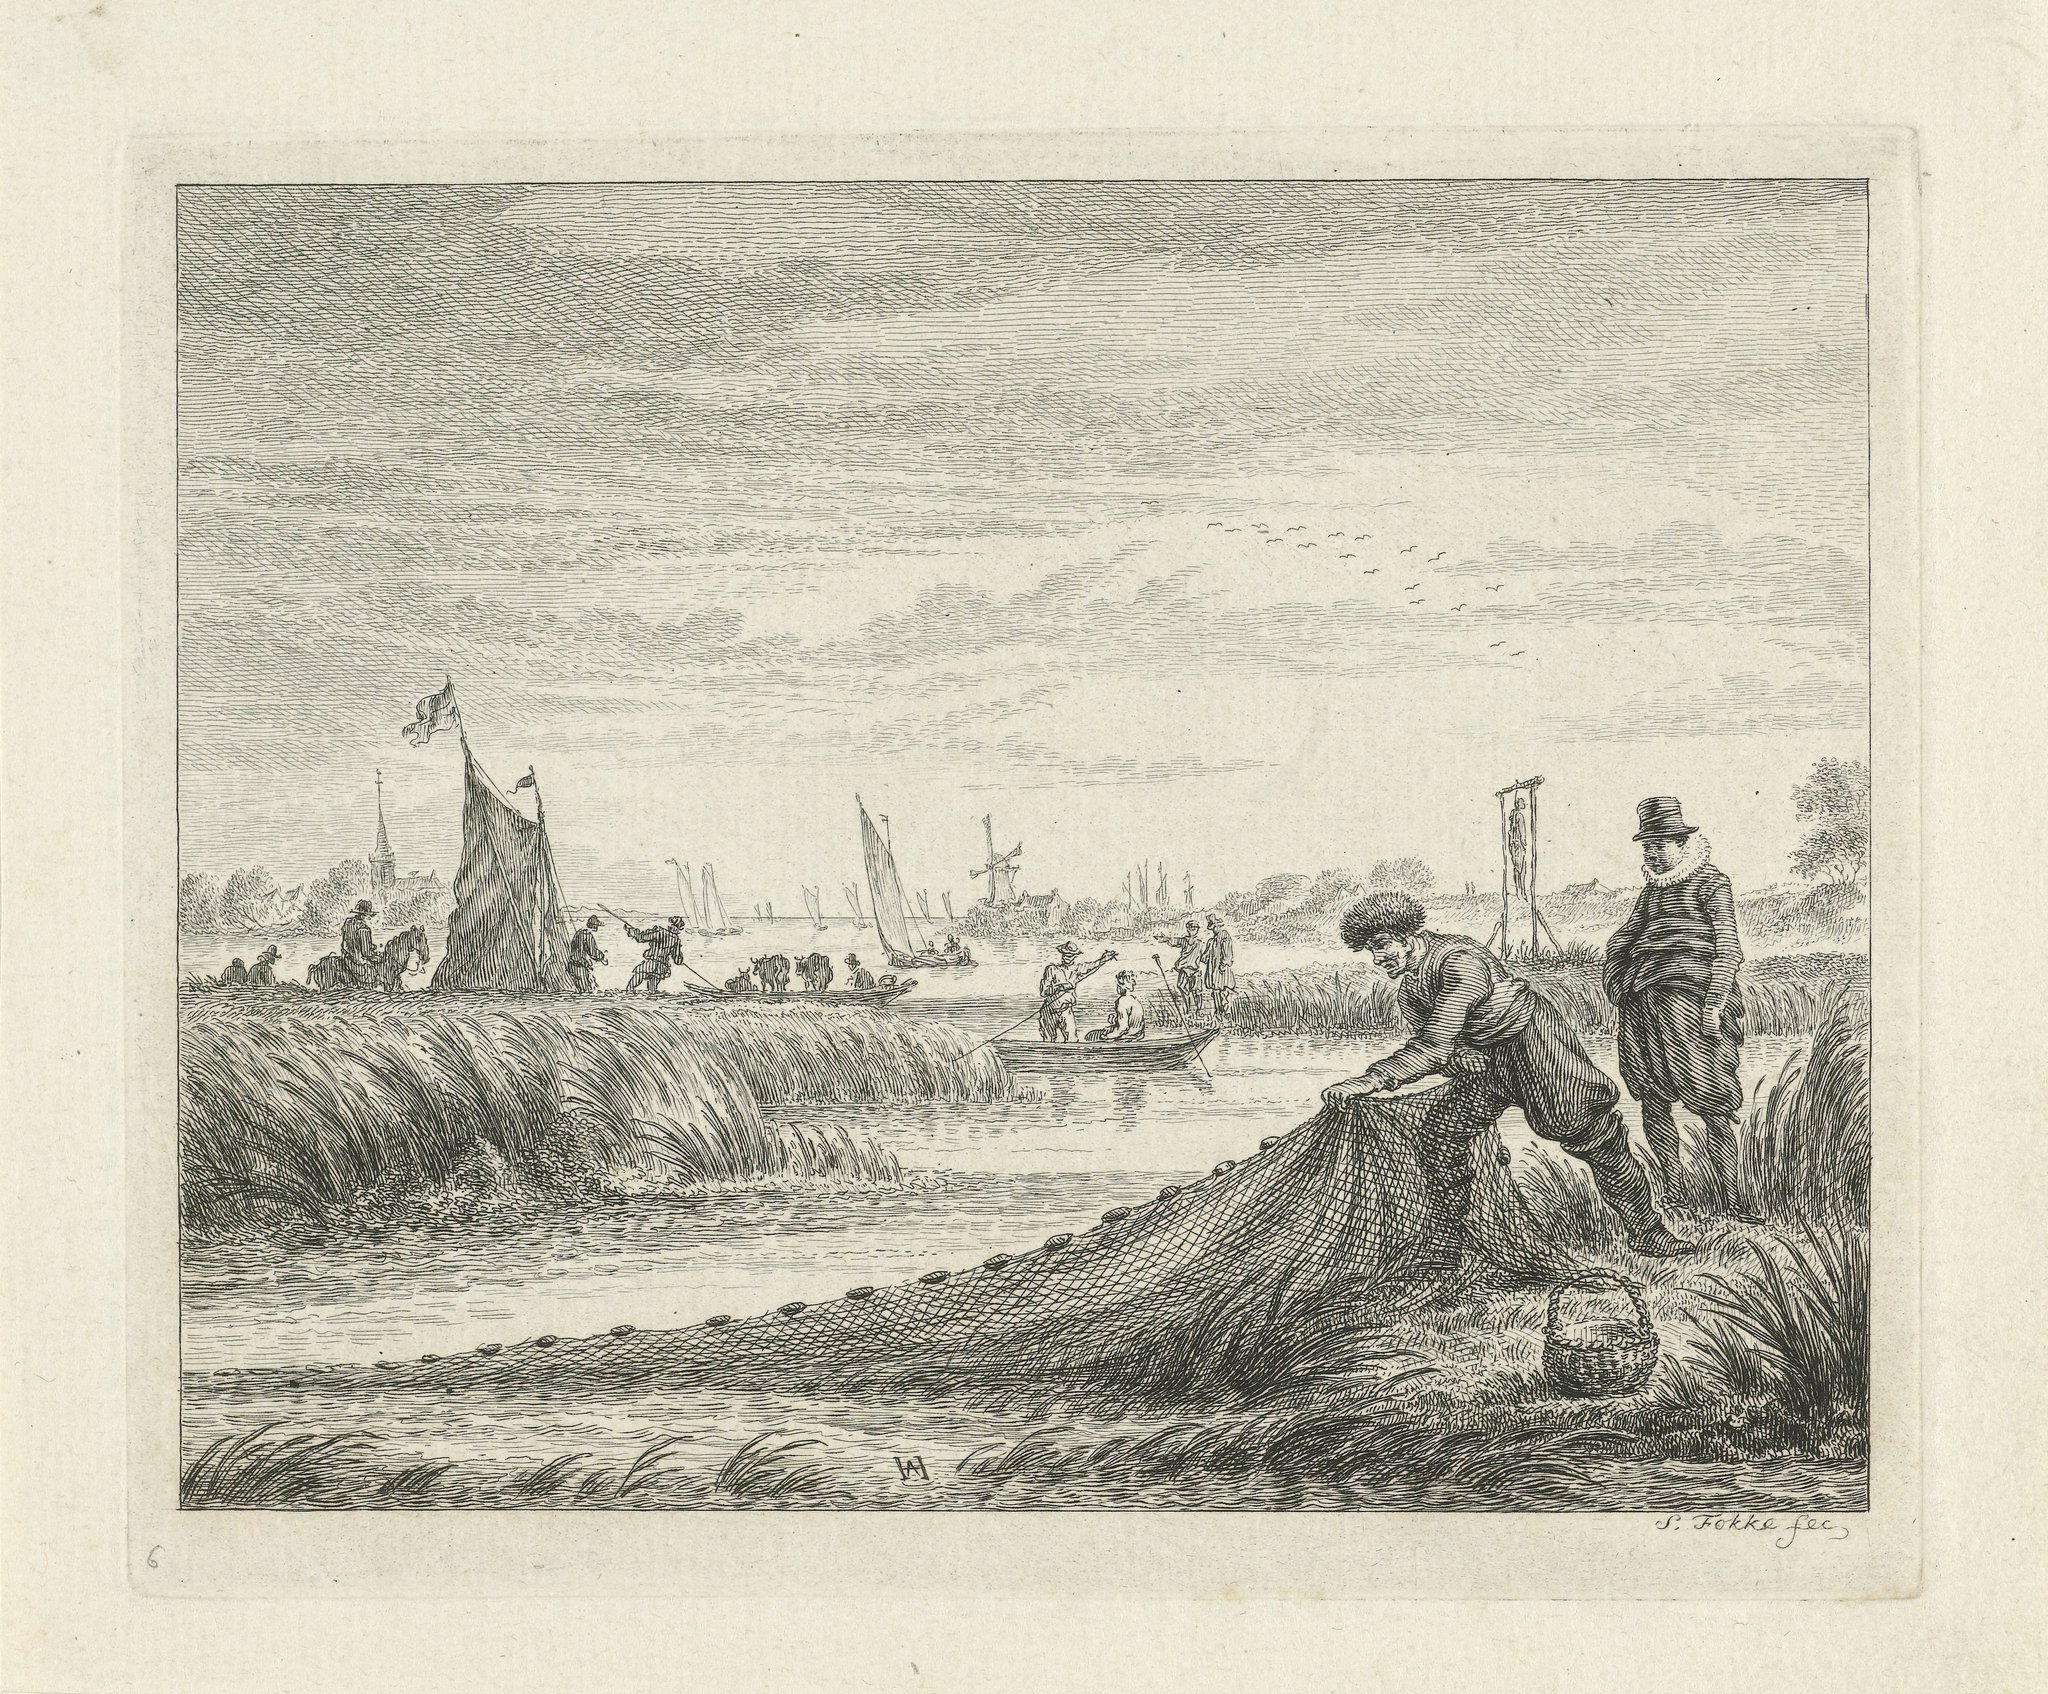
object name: print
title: Rivierlandschap met boten nabij Amstelveen, 1624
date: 1722-1784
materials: paper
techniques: etching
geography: amsterdam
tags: sailing-ship, sailing-boat, river bank, fisherman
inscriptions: collector's mark: Lugt 240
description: Rivierlandschap met boten nabij Amstelveen. Op de oever kijkt een figuur toe hoe een visser zijn visnet op het droge trekt. Op een oever verderop hangt een lijk aan de galg. In de verte een molen en de kerktoren van Amstelveen.